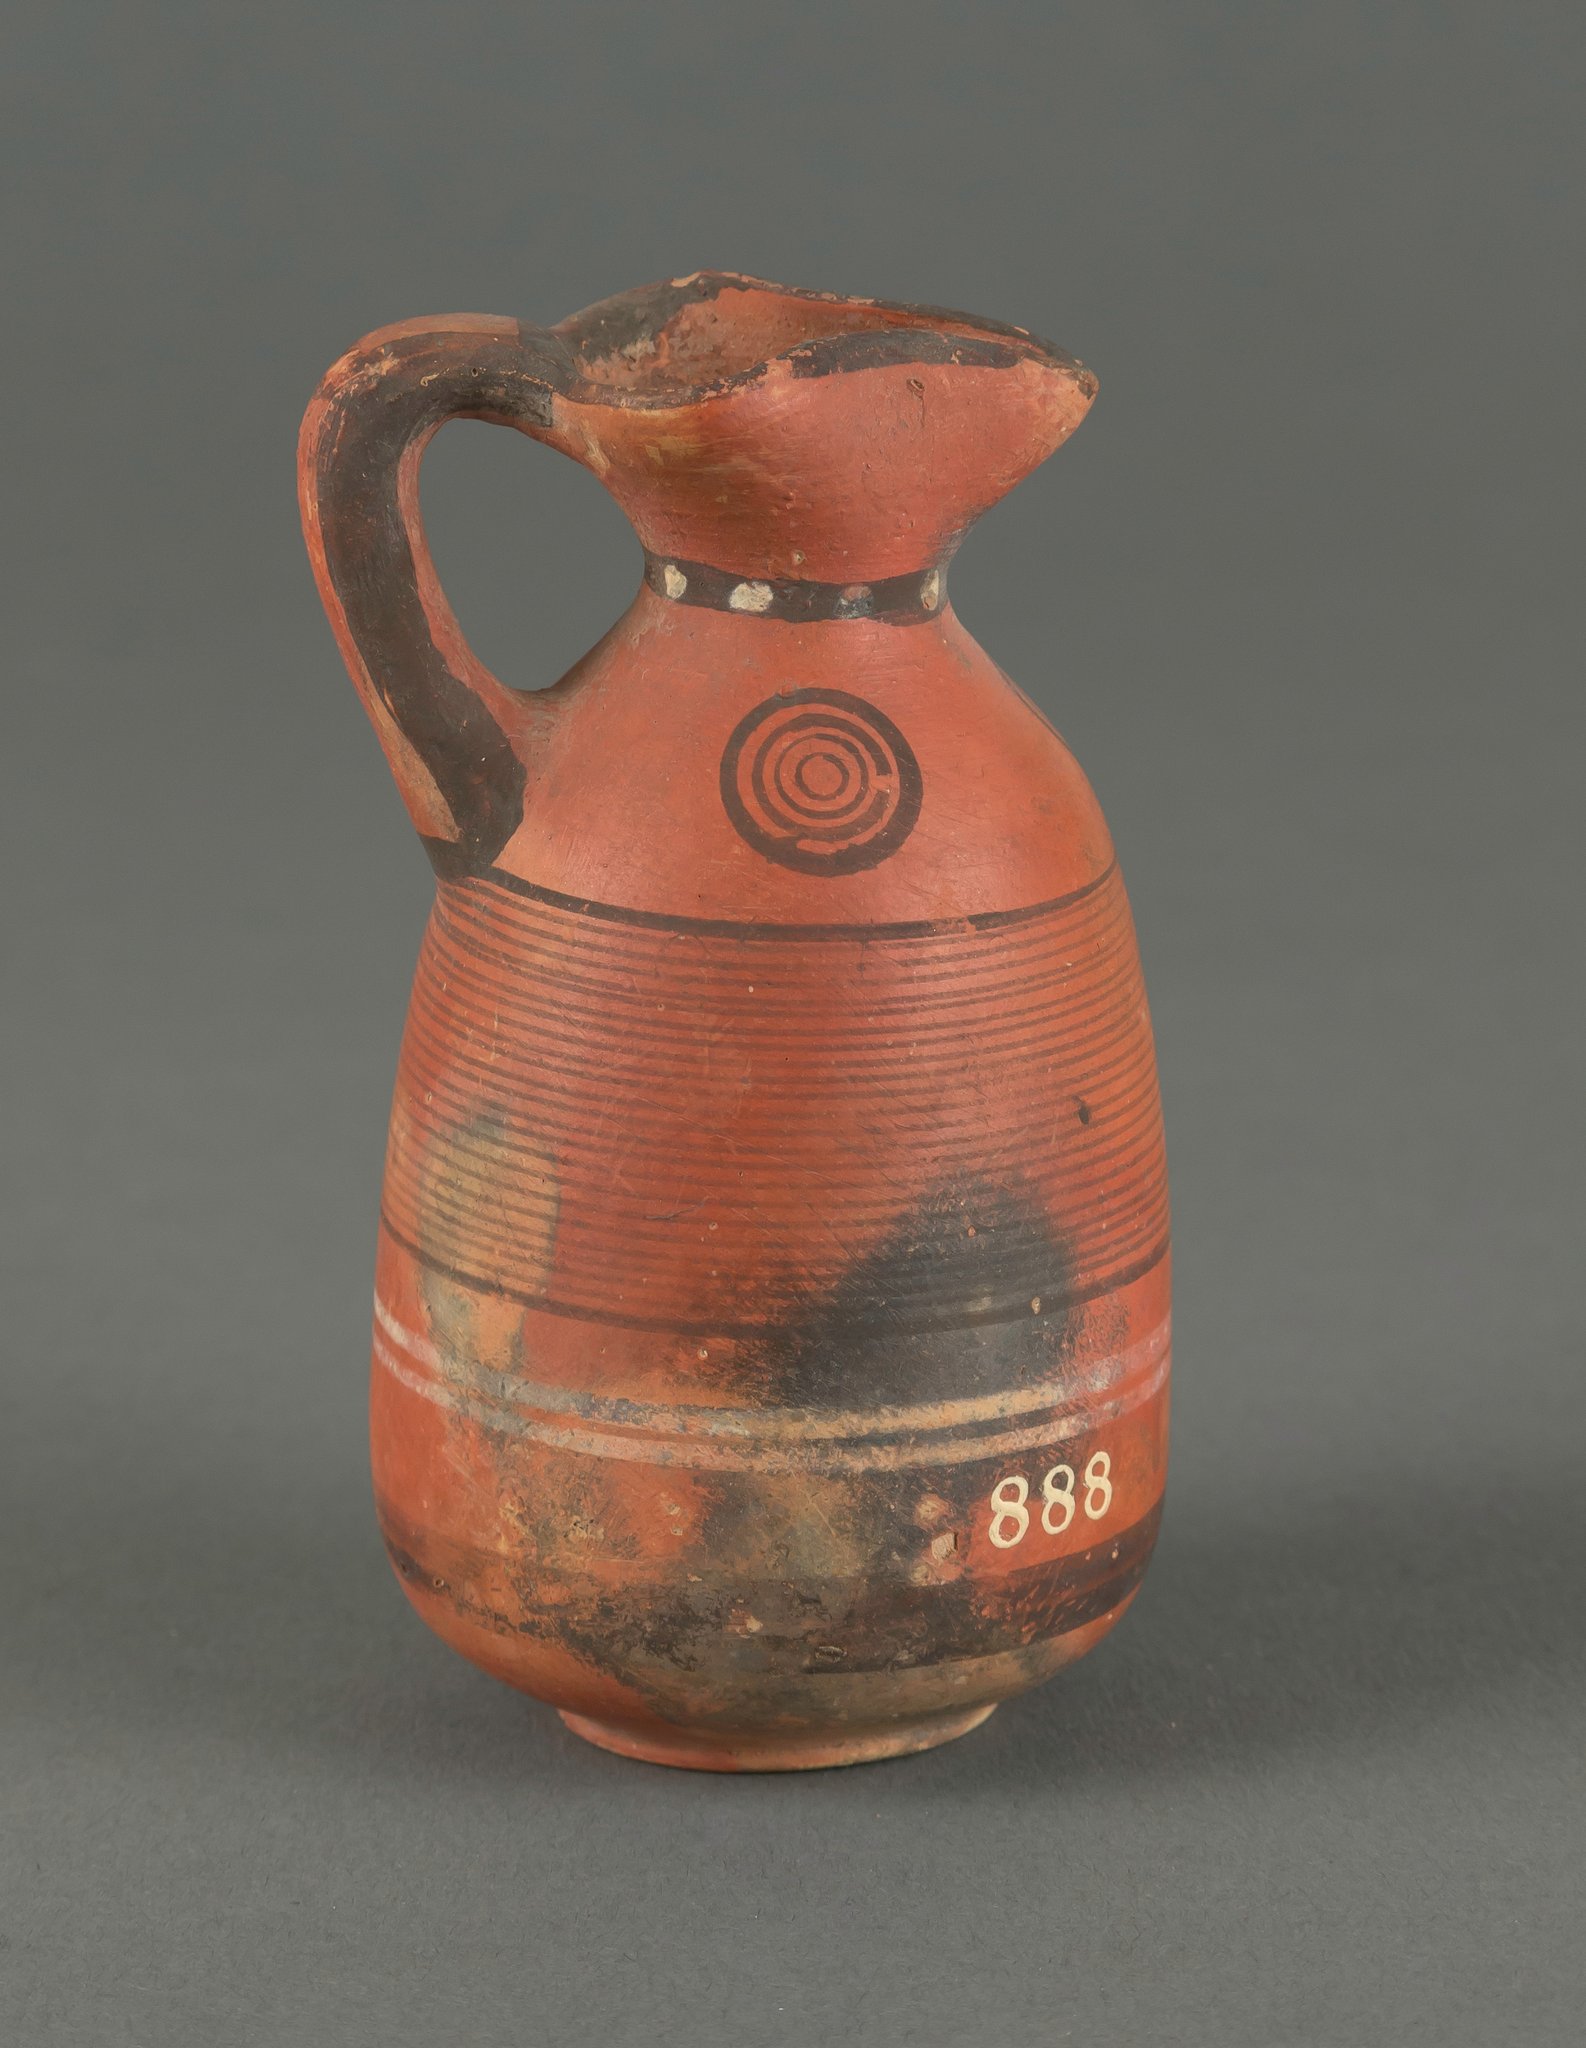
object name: juglet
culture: cypriot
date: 750-600 BCE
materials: terracotta